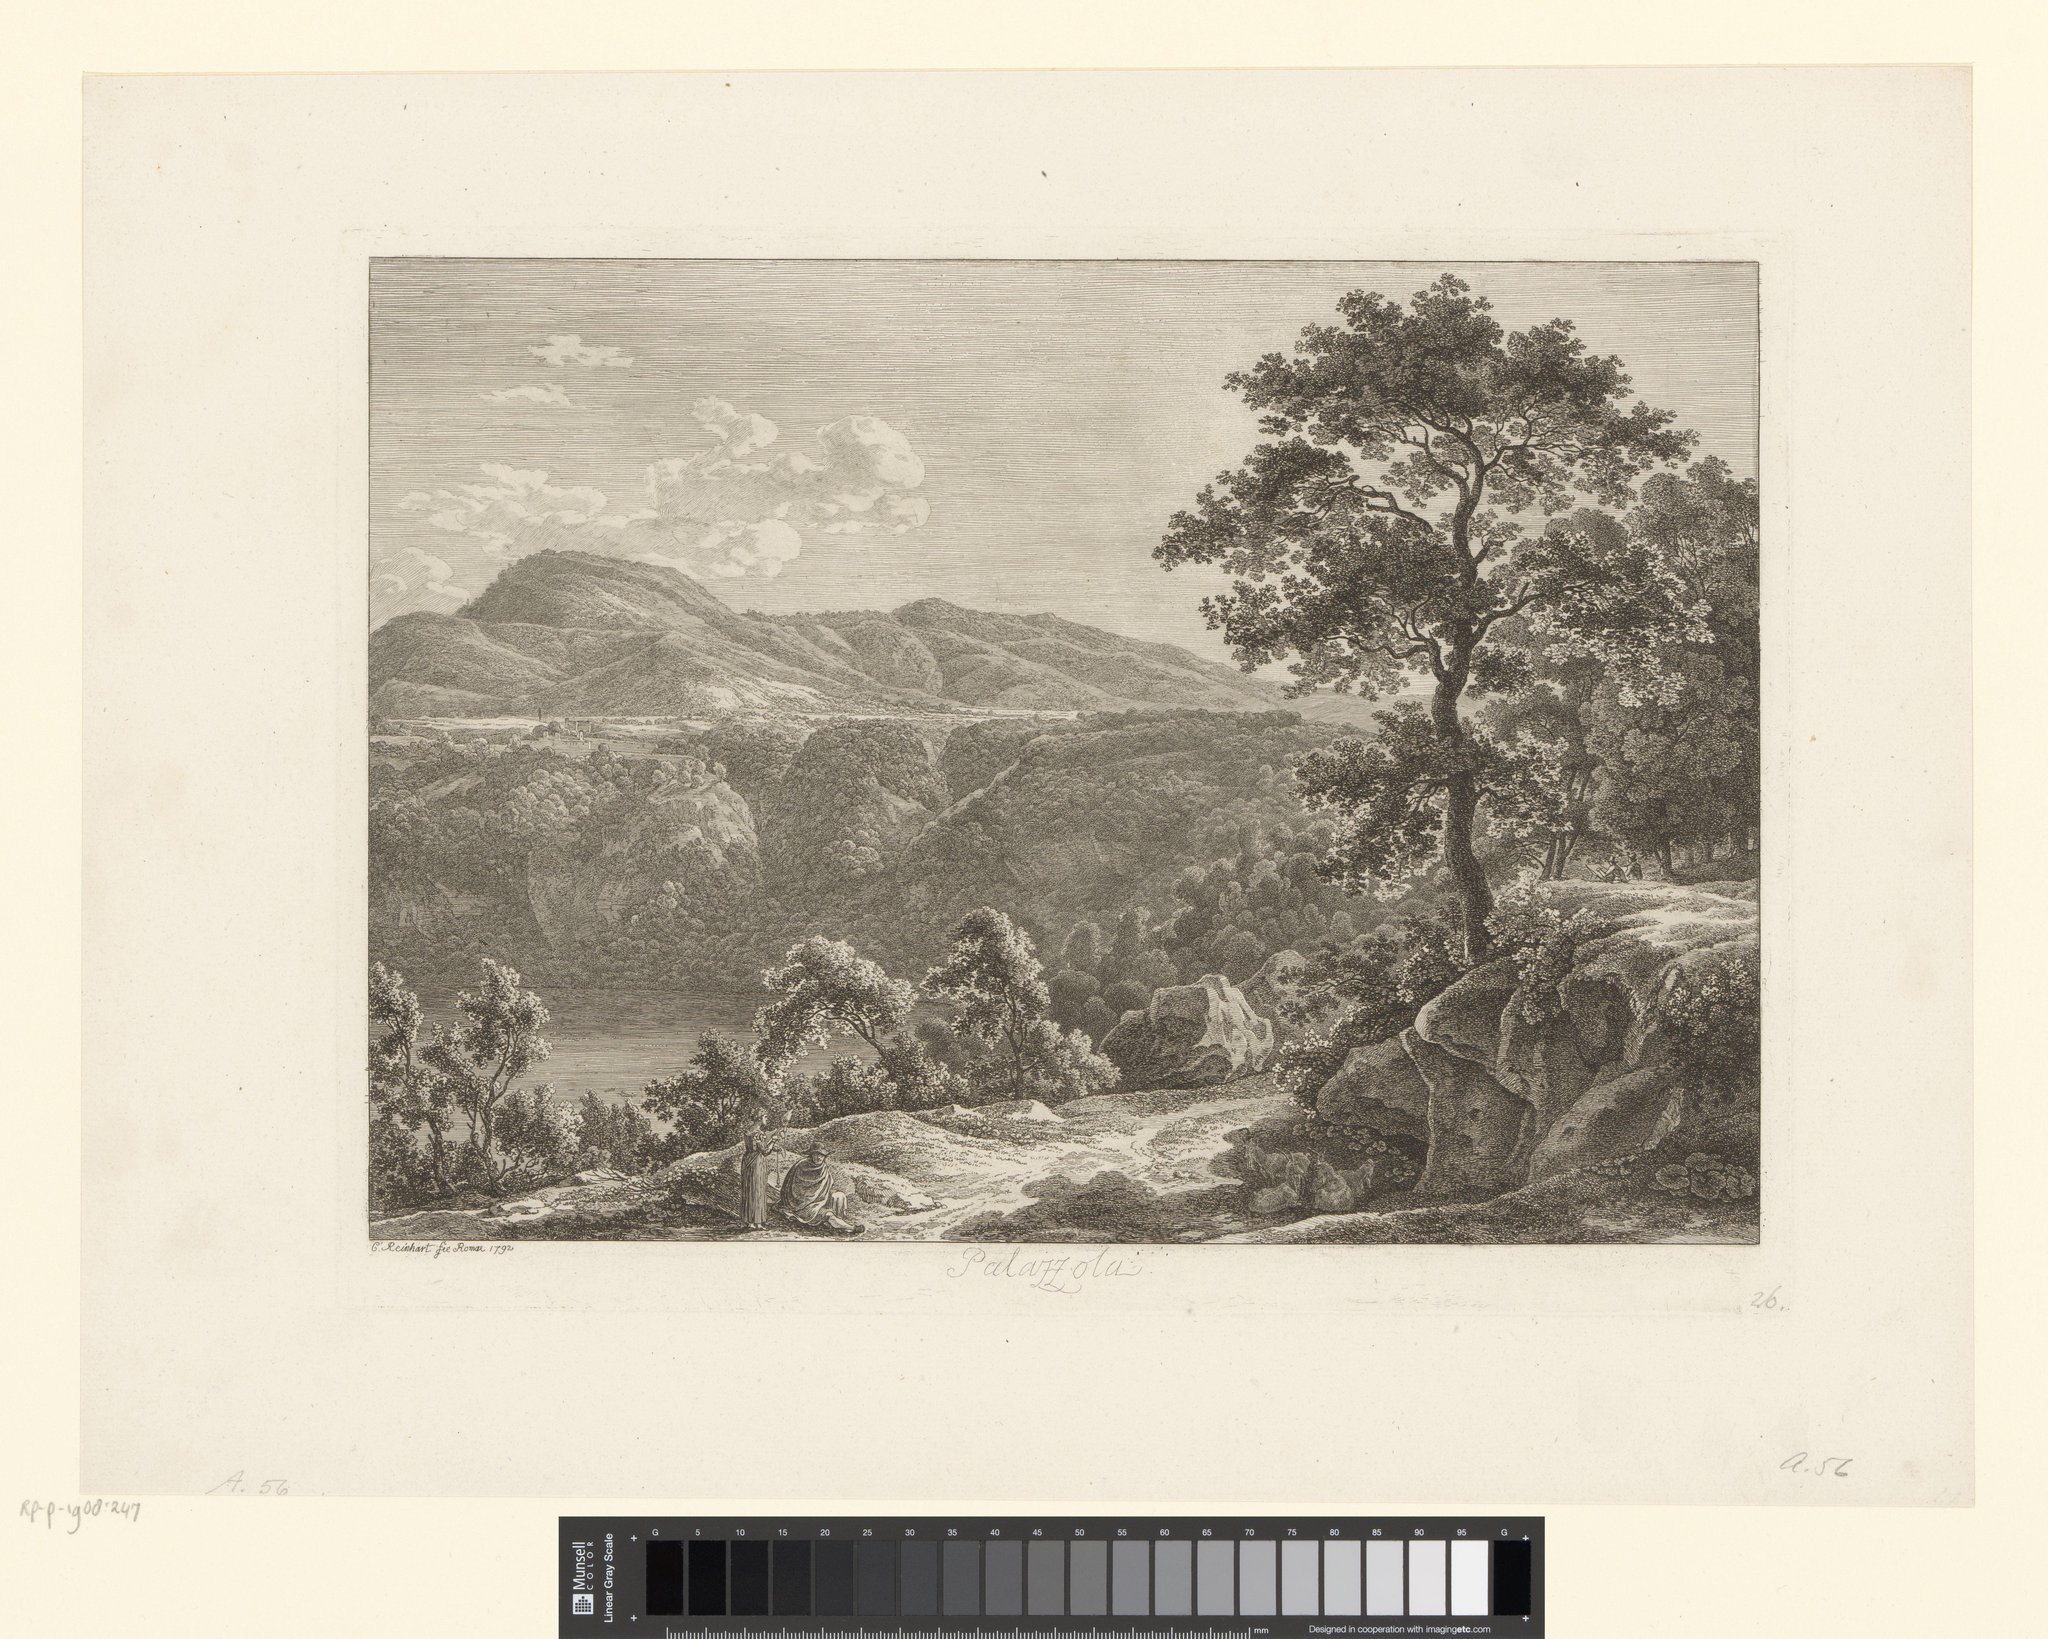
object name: print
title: Palazzola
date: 1792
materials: paper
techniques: engraving, etching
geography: nuremberg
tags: landscapes, landscape with monument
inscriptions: collector's mark: Lugt 2228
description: Behorend tot een serie van 72 'Mahlerisch-radirte Prospecte von Italien', waarvoor de kunstenaar 24 prenten maakte. Albert Christoph Dies (1755-1822) en Jacob Wilhelm Mechau (1745-1808) maakten eveneens 24 platen, in opdracht van Jean Fréderic Frauenholz. Vanaf 1792 verschenen telkens drie sets van twee prenten per kunstenaar. In 1798 werd de laatste set uitgegeven, waarna complete sets gebonden werden uitgegeven tot in 1875 (Nuerenberg: J.L. Lotzbeck). Zie: Schmid, F.C., A.C. Dies, J.W. Mechau und J.C. Reinhart 'Mahlerische radirte Prospecte von Italien' (...). Berlijn: s.n., 1991.